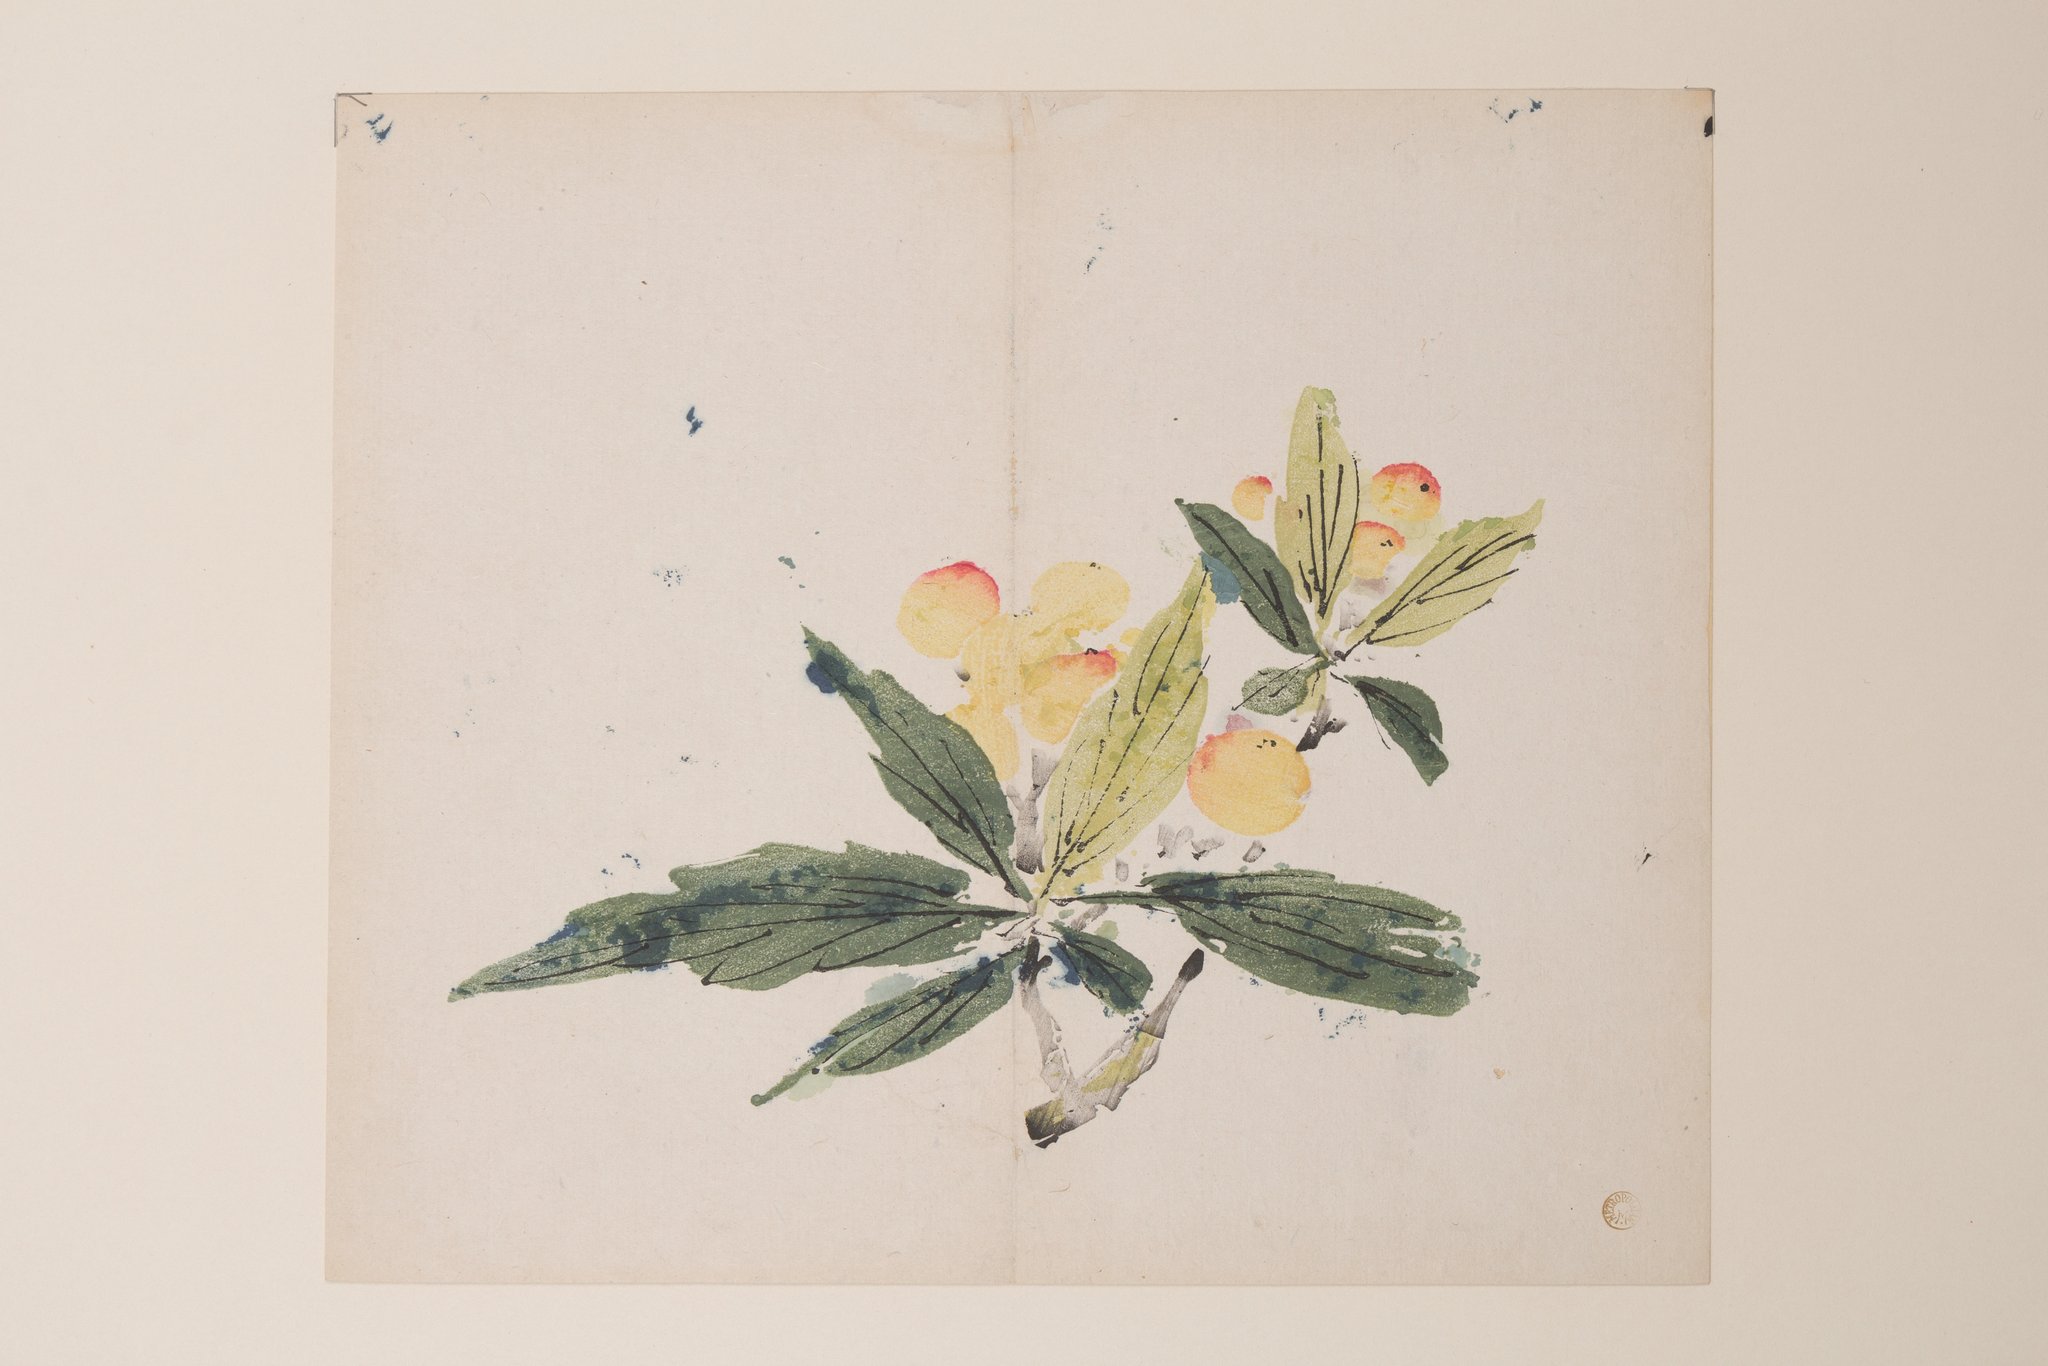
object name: print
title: Page from the Ten Bamboo Studio Manual of Painting and Calligraphy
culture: chinese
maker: hu zhengyan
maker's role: artist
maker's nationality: chinese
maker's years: 1584-1634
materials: ink, paper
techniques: printing